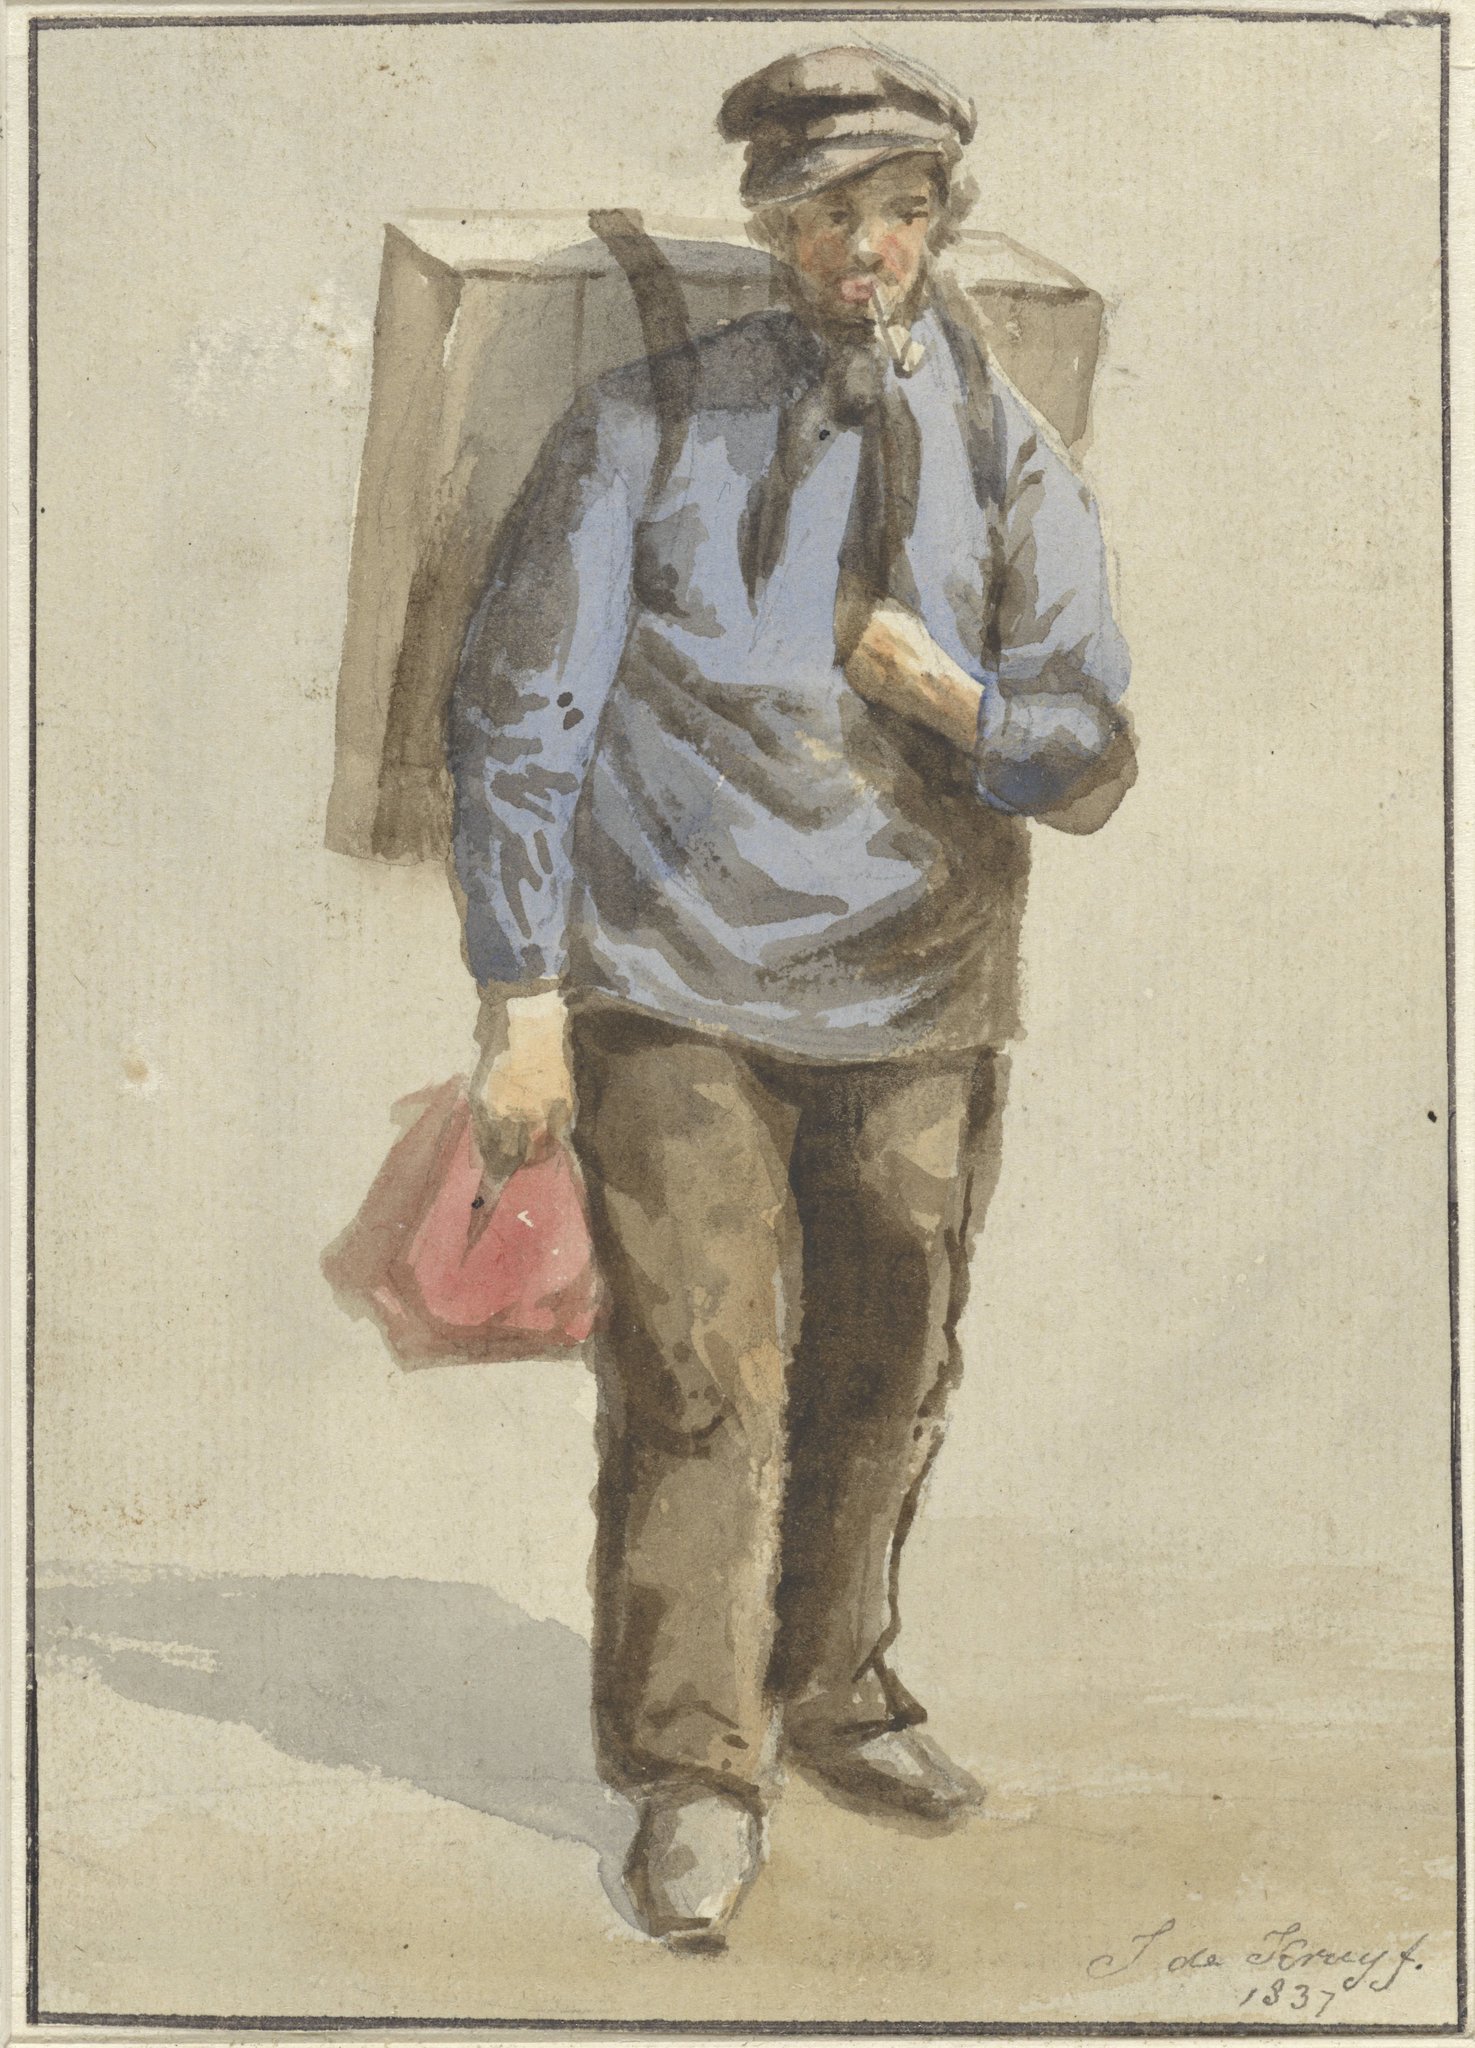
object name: watercolor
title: Portret van Gerrit van Schoorl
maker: j. de kruyff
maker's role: draughtsman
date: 1837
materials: paper, watercolor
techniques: brush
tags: print, e.g.: engraving, etching, lithograph, historical persons, wandering or travelling merchant, art dealer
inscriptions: inscription: ‘Gerrit van Schoorl/ Plattelands prente koopman te Alkmaar/ 1837’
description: Portret van Gerrit van Schoorl, volgens het opschrift op verso 'Plattelands prente koopman te Alkmaar'. Een dergelijke prentenkoopman of prentverkoper was in feite een marskramer die rondtrekkend van plaats naar plaats prenten verkocht.